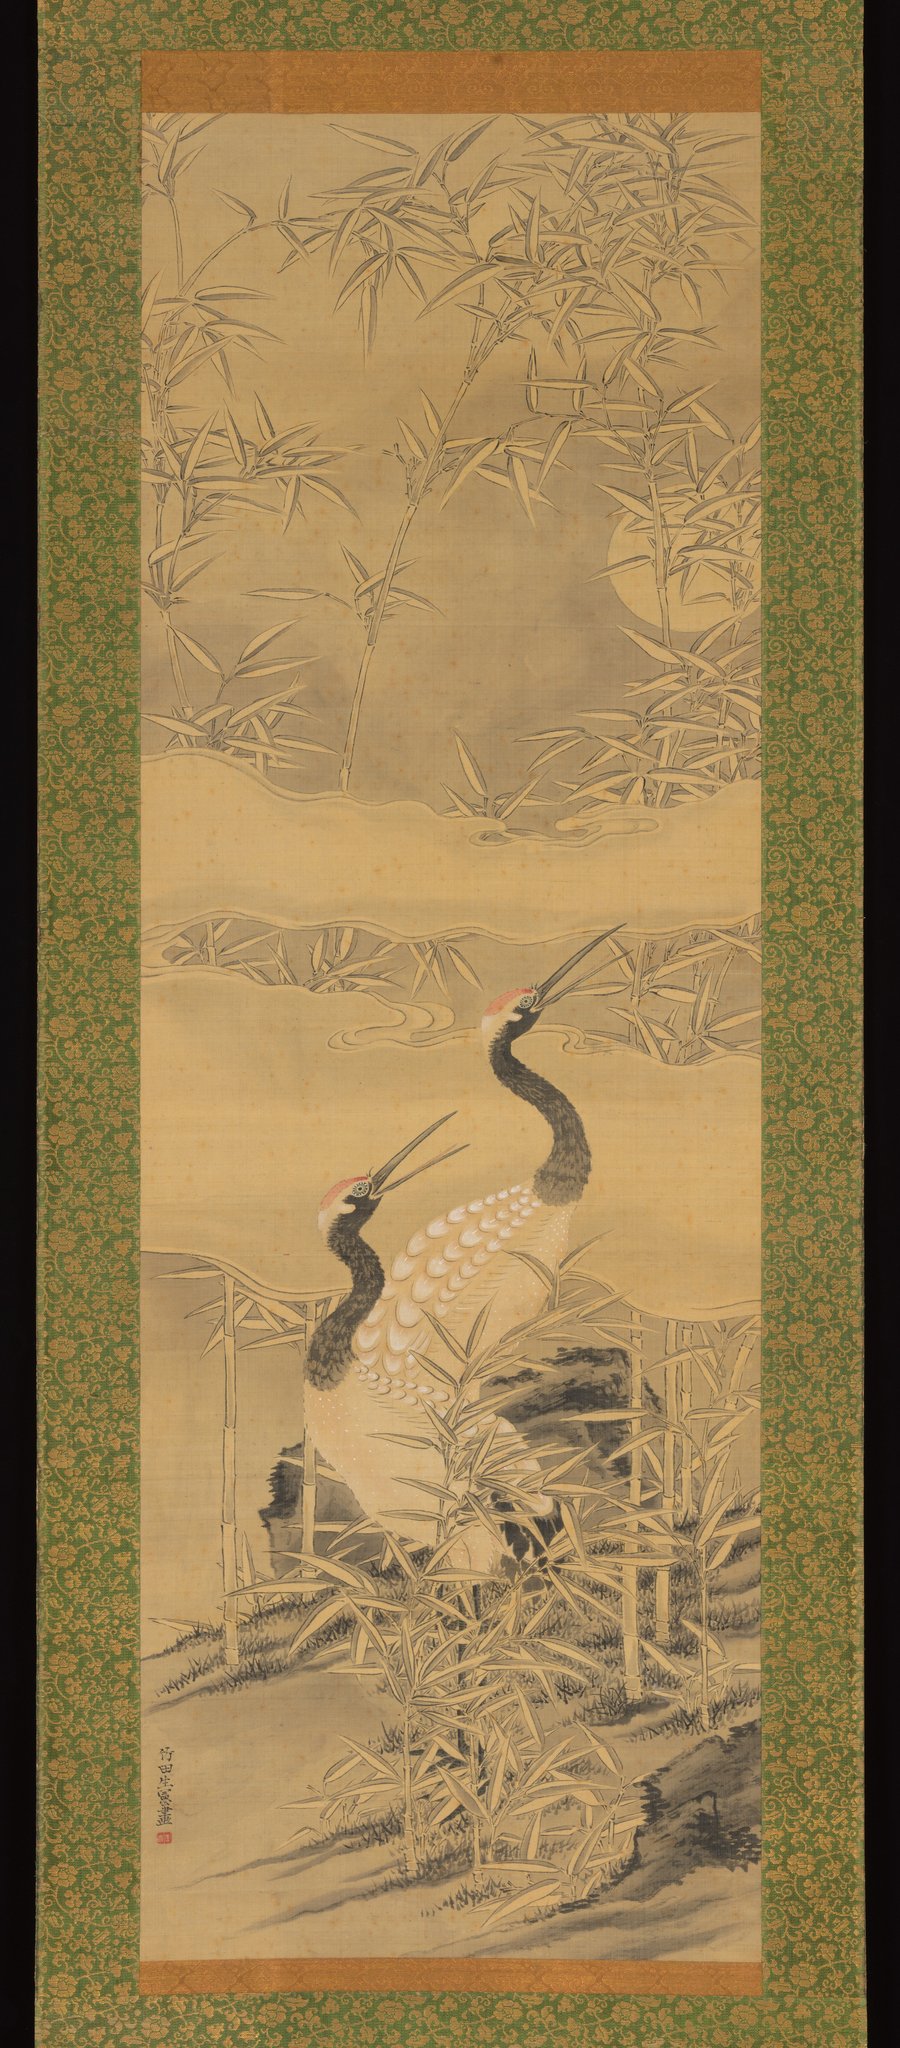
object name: hanging scroll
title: Pair of Cranes in Bamboo Grove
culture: japanese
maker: tanomura chikuden 田能村竹田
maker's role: artist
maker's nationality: japanese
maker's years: 1777-1835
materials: ink, silk